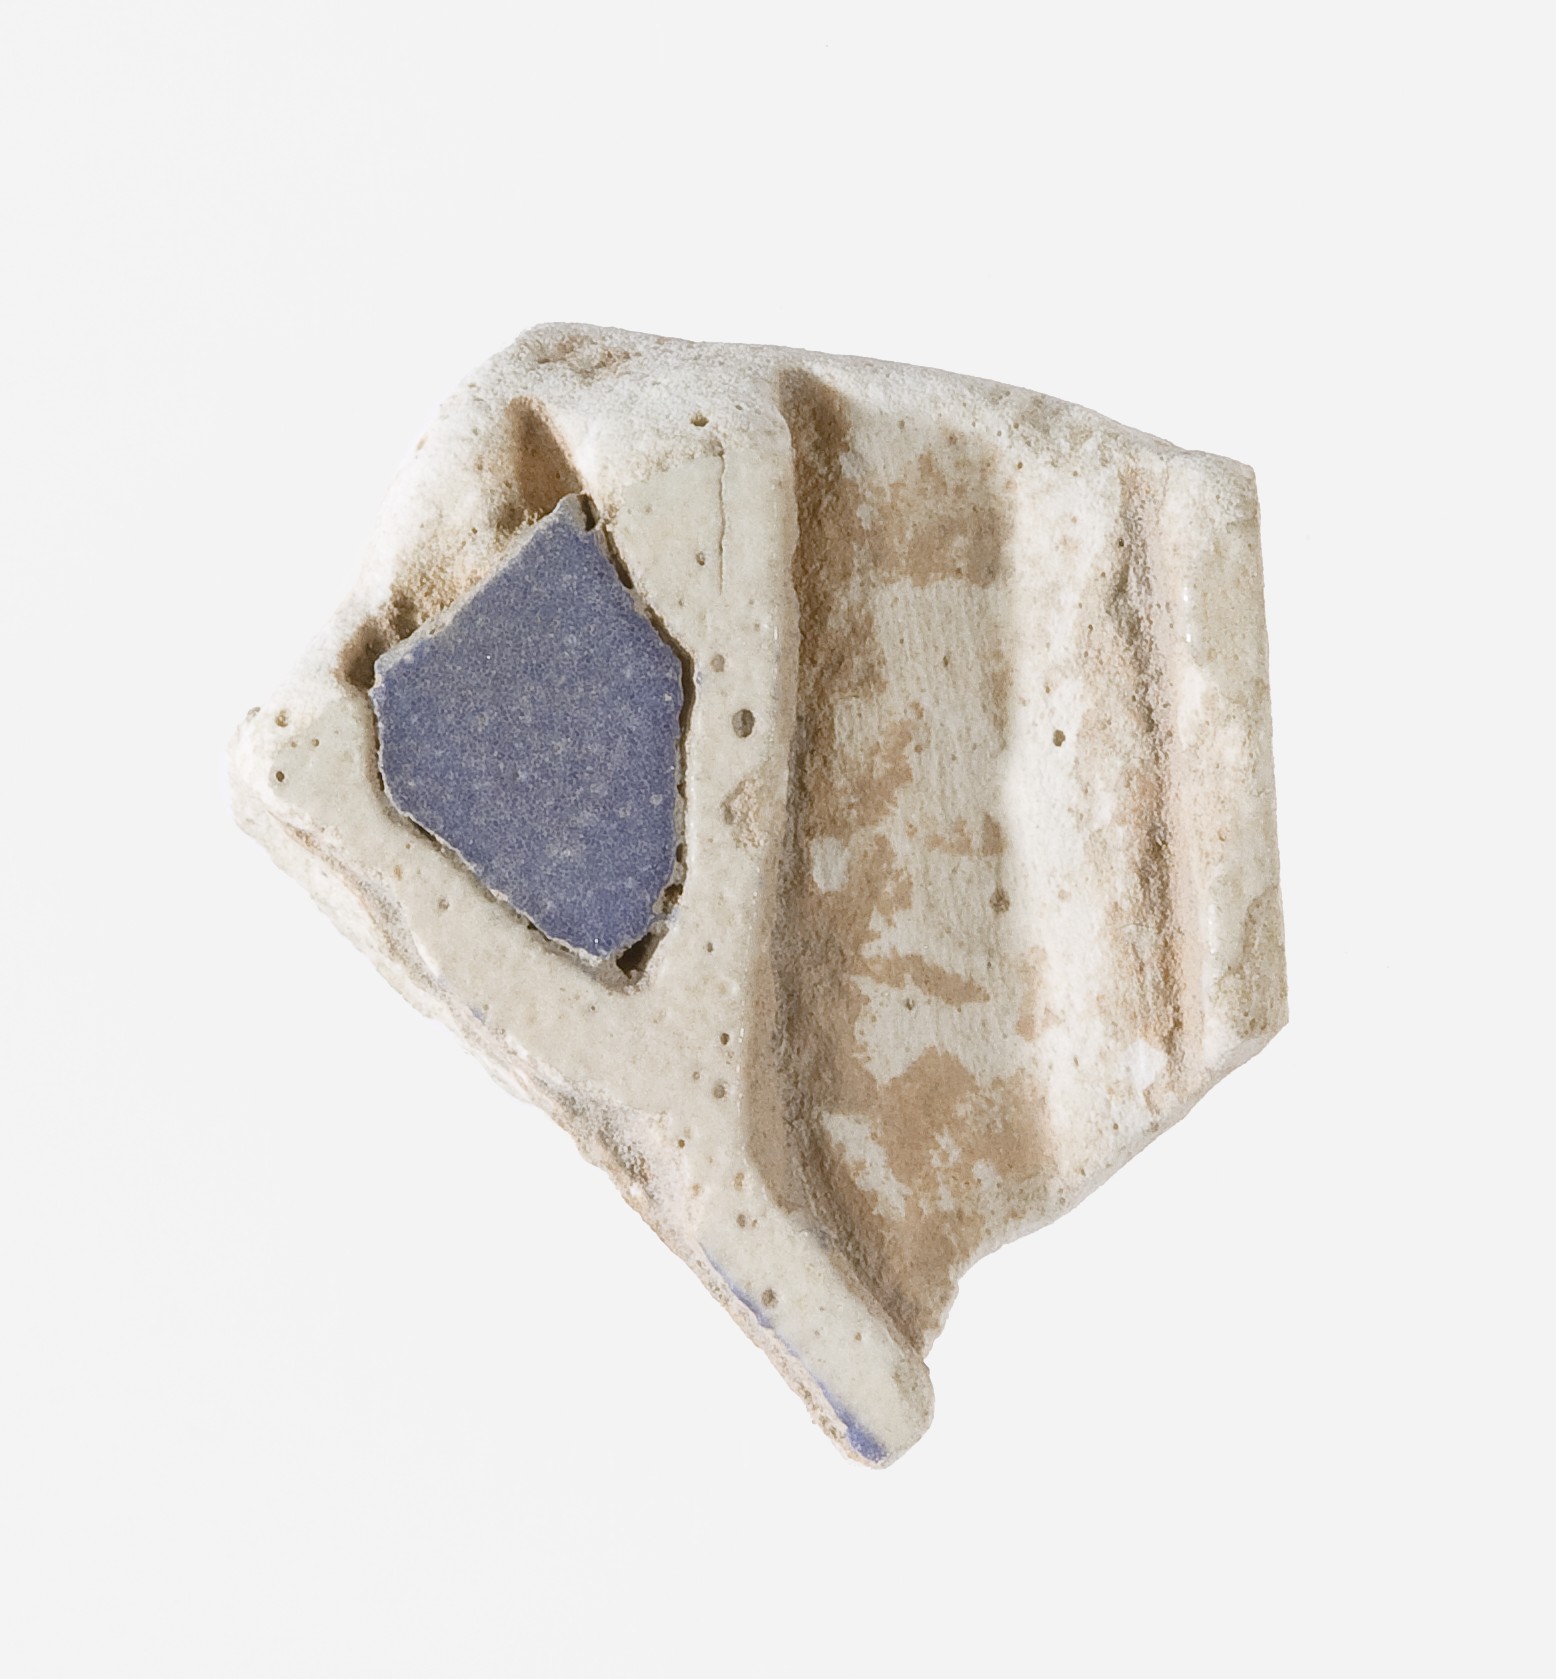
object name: necklace terminal, lotus collar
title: Fragment of Lotus Collar Terminals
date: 1390-1352 BCE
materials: faience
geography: egypt